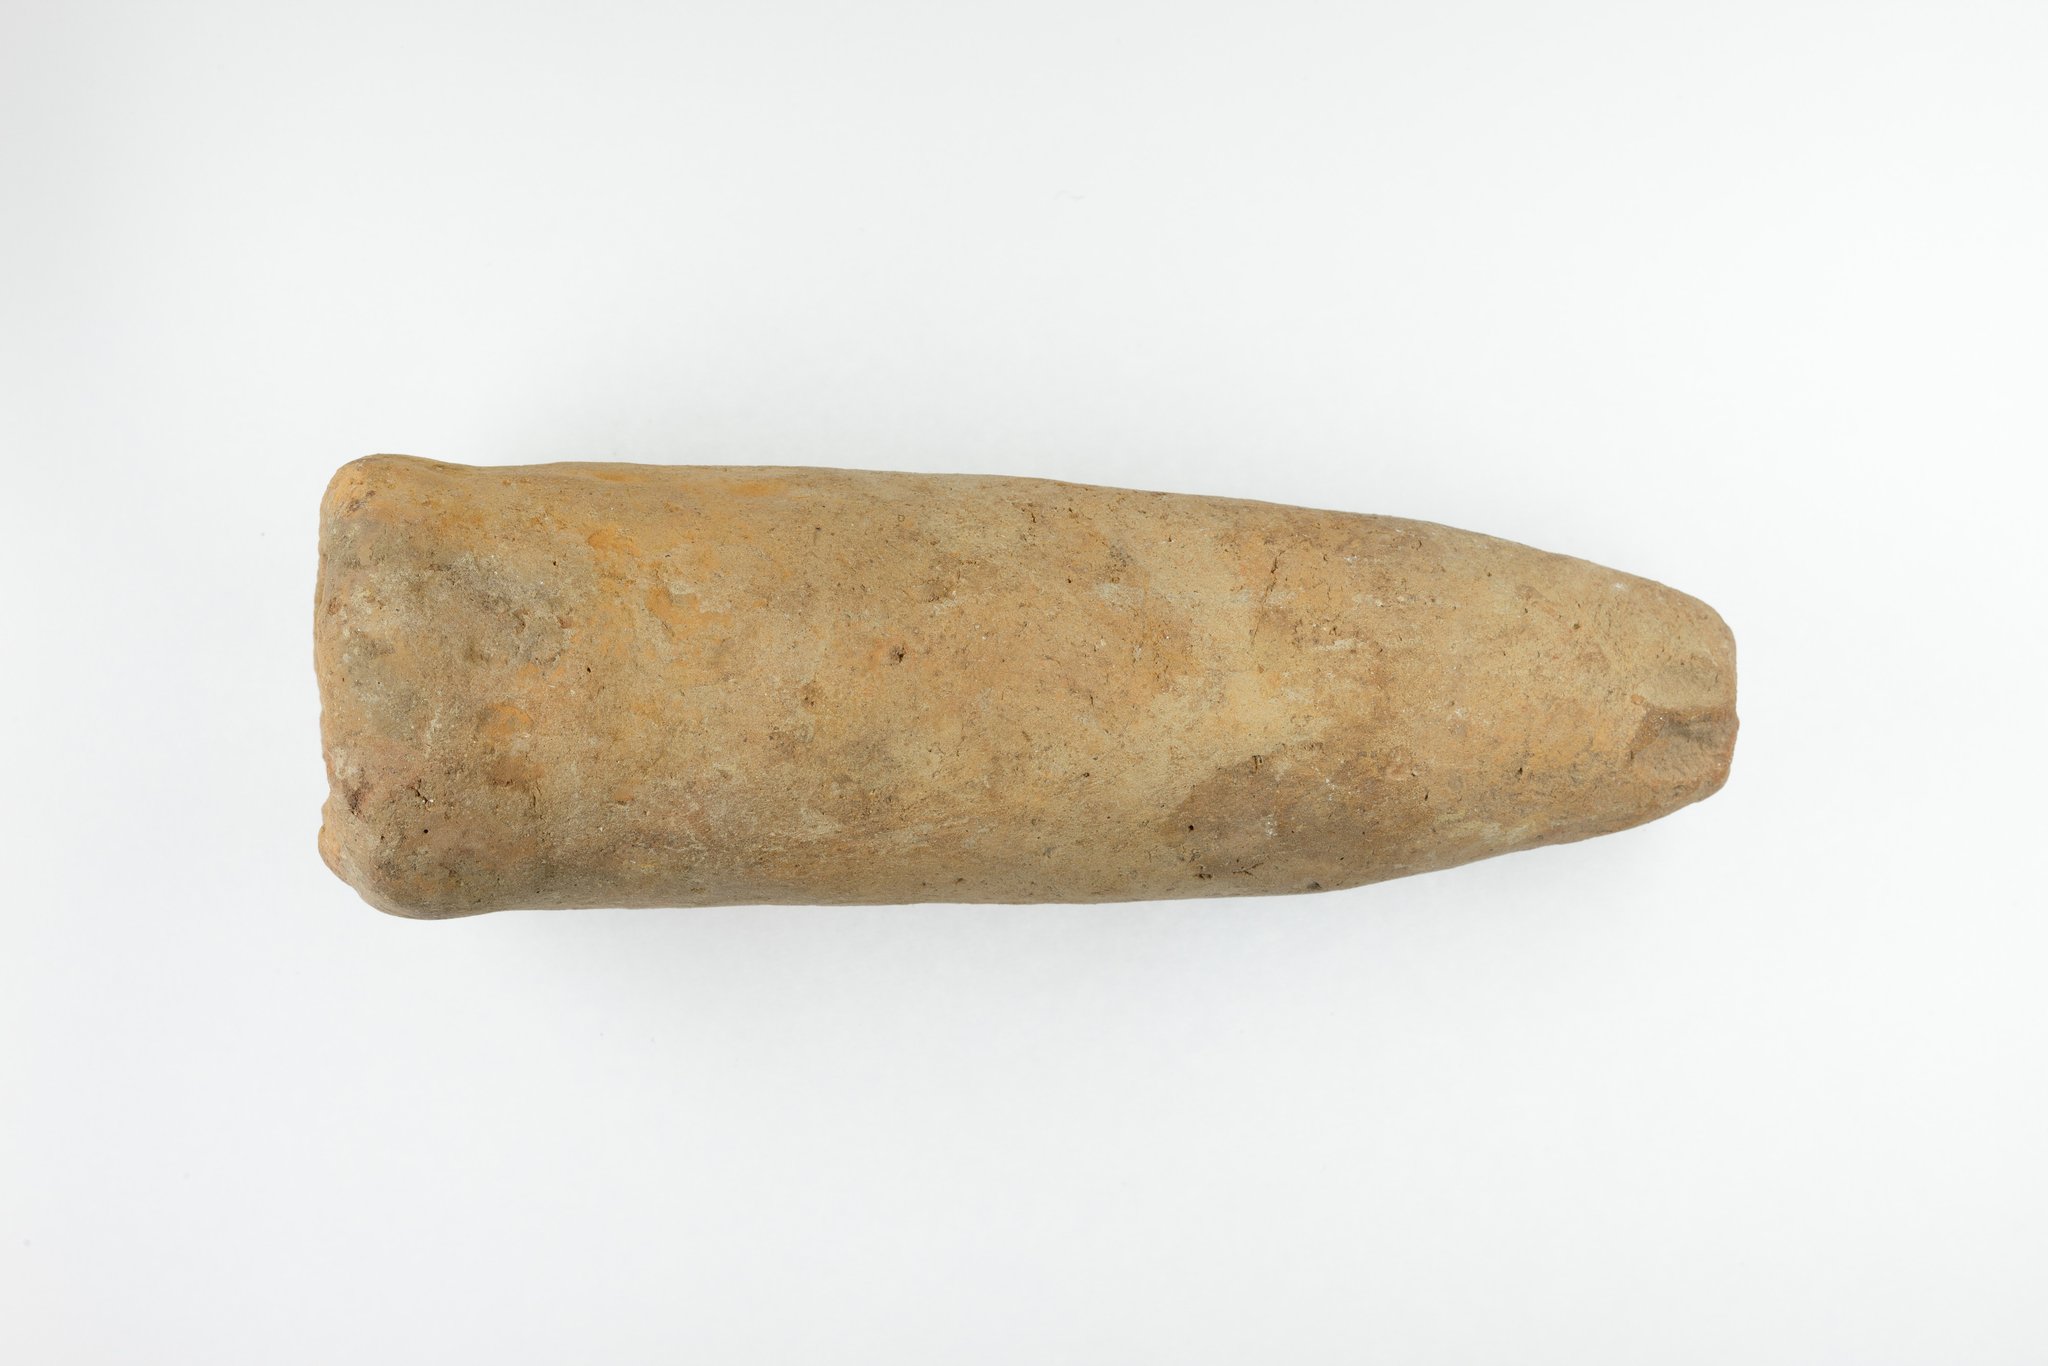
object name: crucible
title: Smelter's Crucible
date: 1479-1458 BCE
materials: pottery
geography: egypt